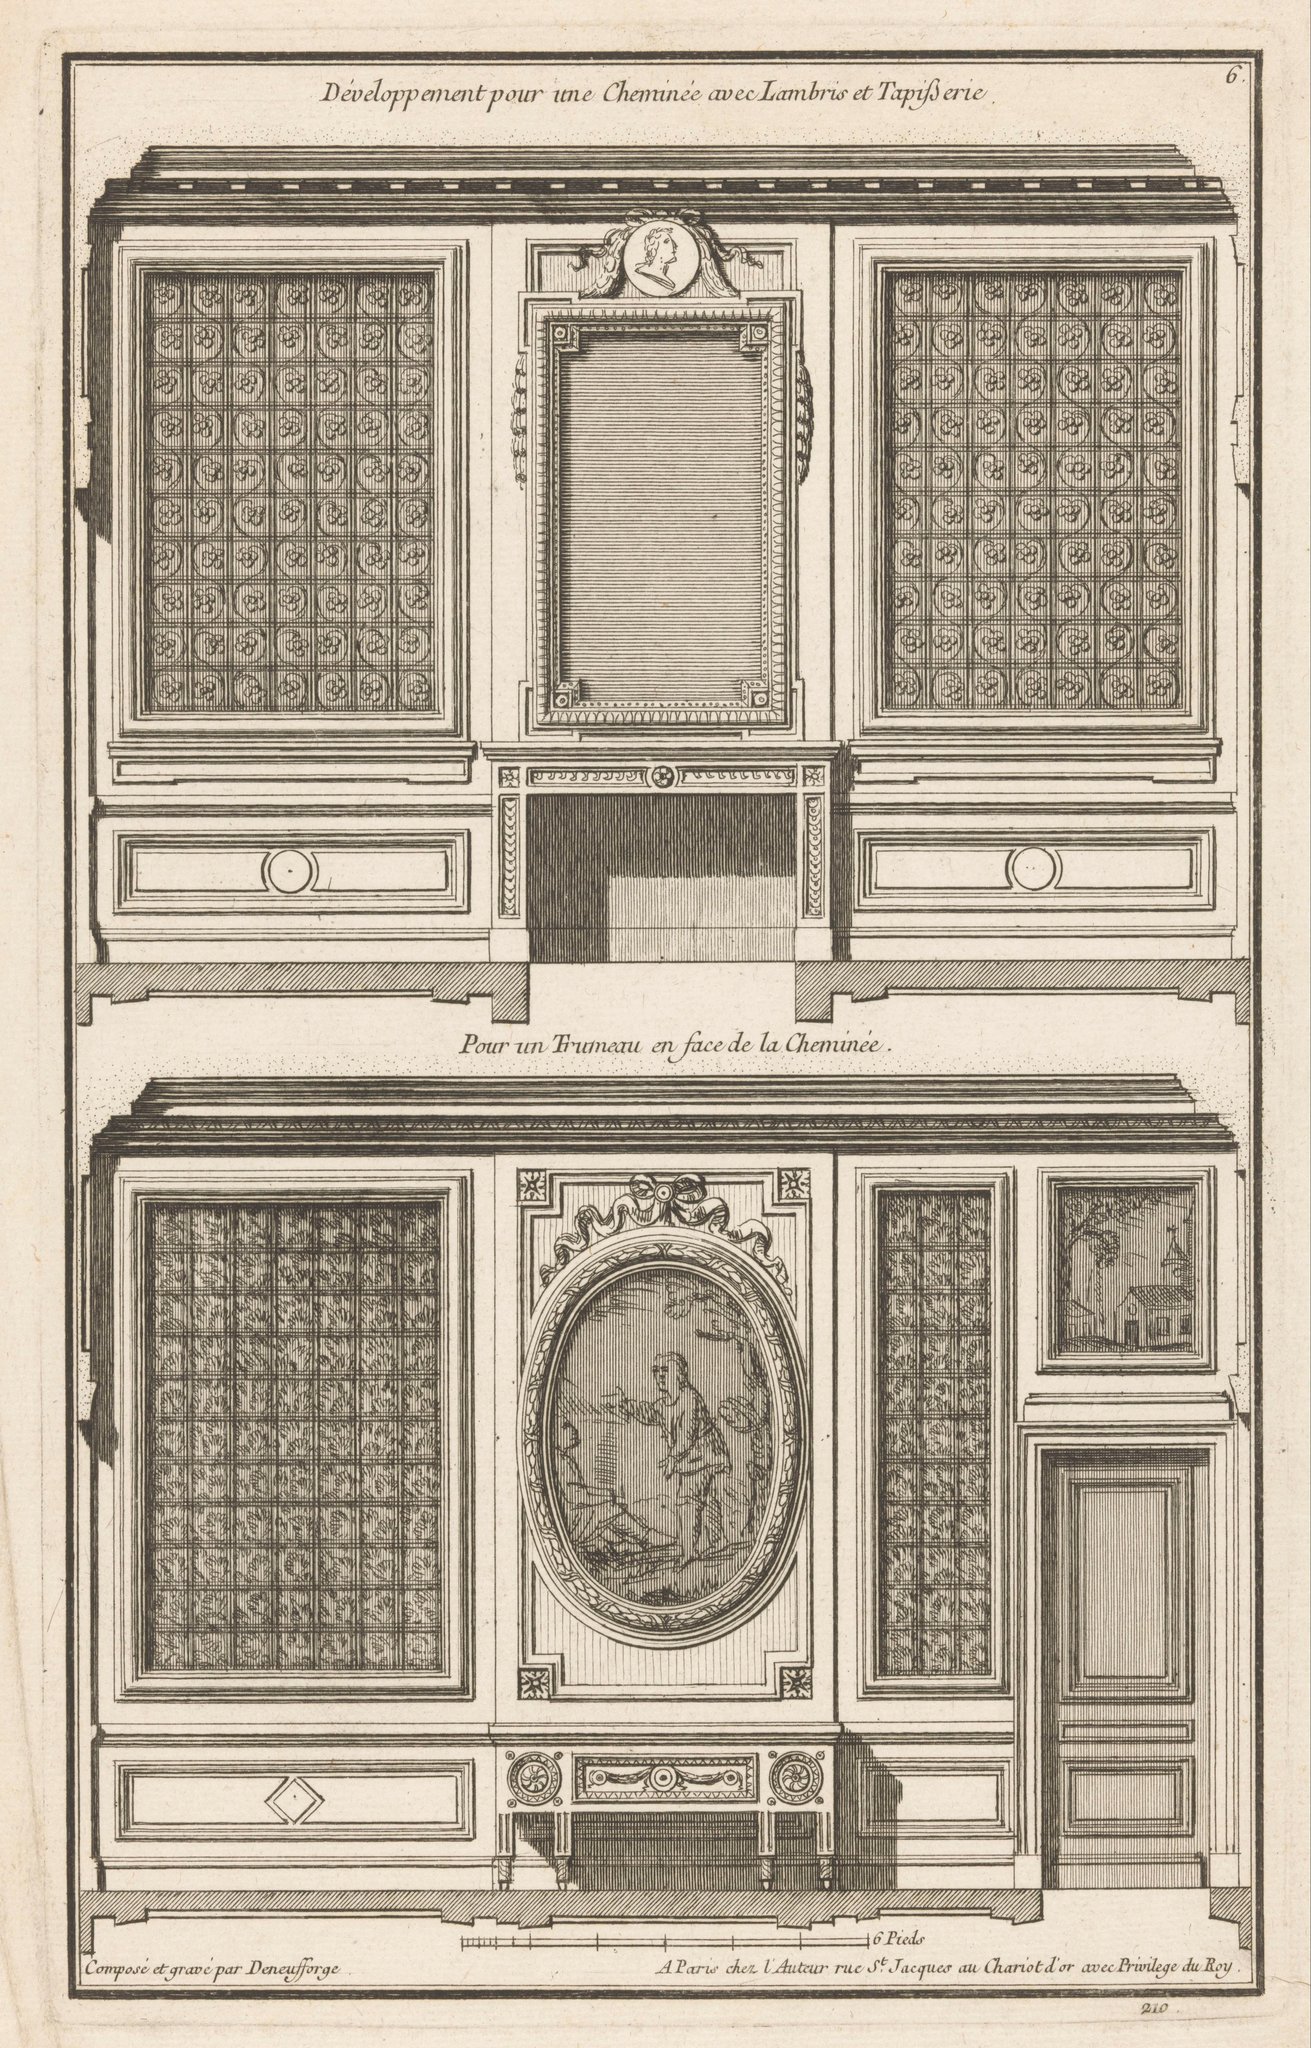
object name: print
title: Schouw, wandtapijten en trumeau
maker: jean françois de neufforge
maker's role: print maker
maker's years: 1714-1791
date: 1760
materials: paper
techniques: etching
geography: paris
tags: panelling, open hearth, fire-place, tapestry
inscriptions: collector's mark: Lugt 2760, collector's mark: Lugt 2228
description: Een geornamenteerde schouw met medaillon, geflankeerd door wandtapijten met bloemmotieven. Daaronder een trumeau met groot ovaal medaillon met twee figuren in een landschap. Wandtapijten met bladmotieven flankeren de trumeau. In het midden staat een tafel, rechts een deur. Prentnummer 210.